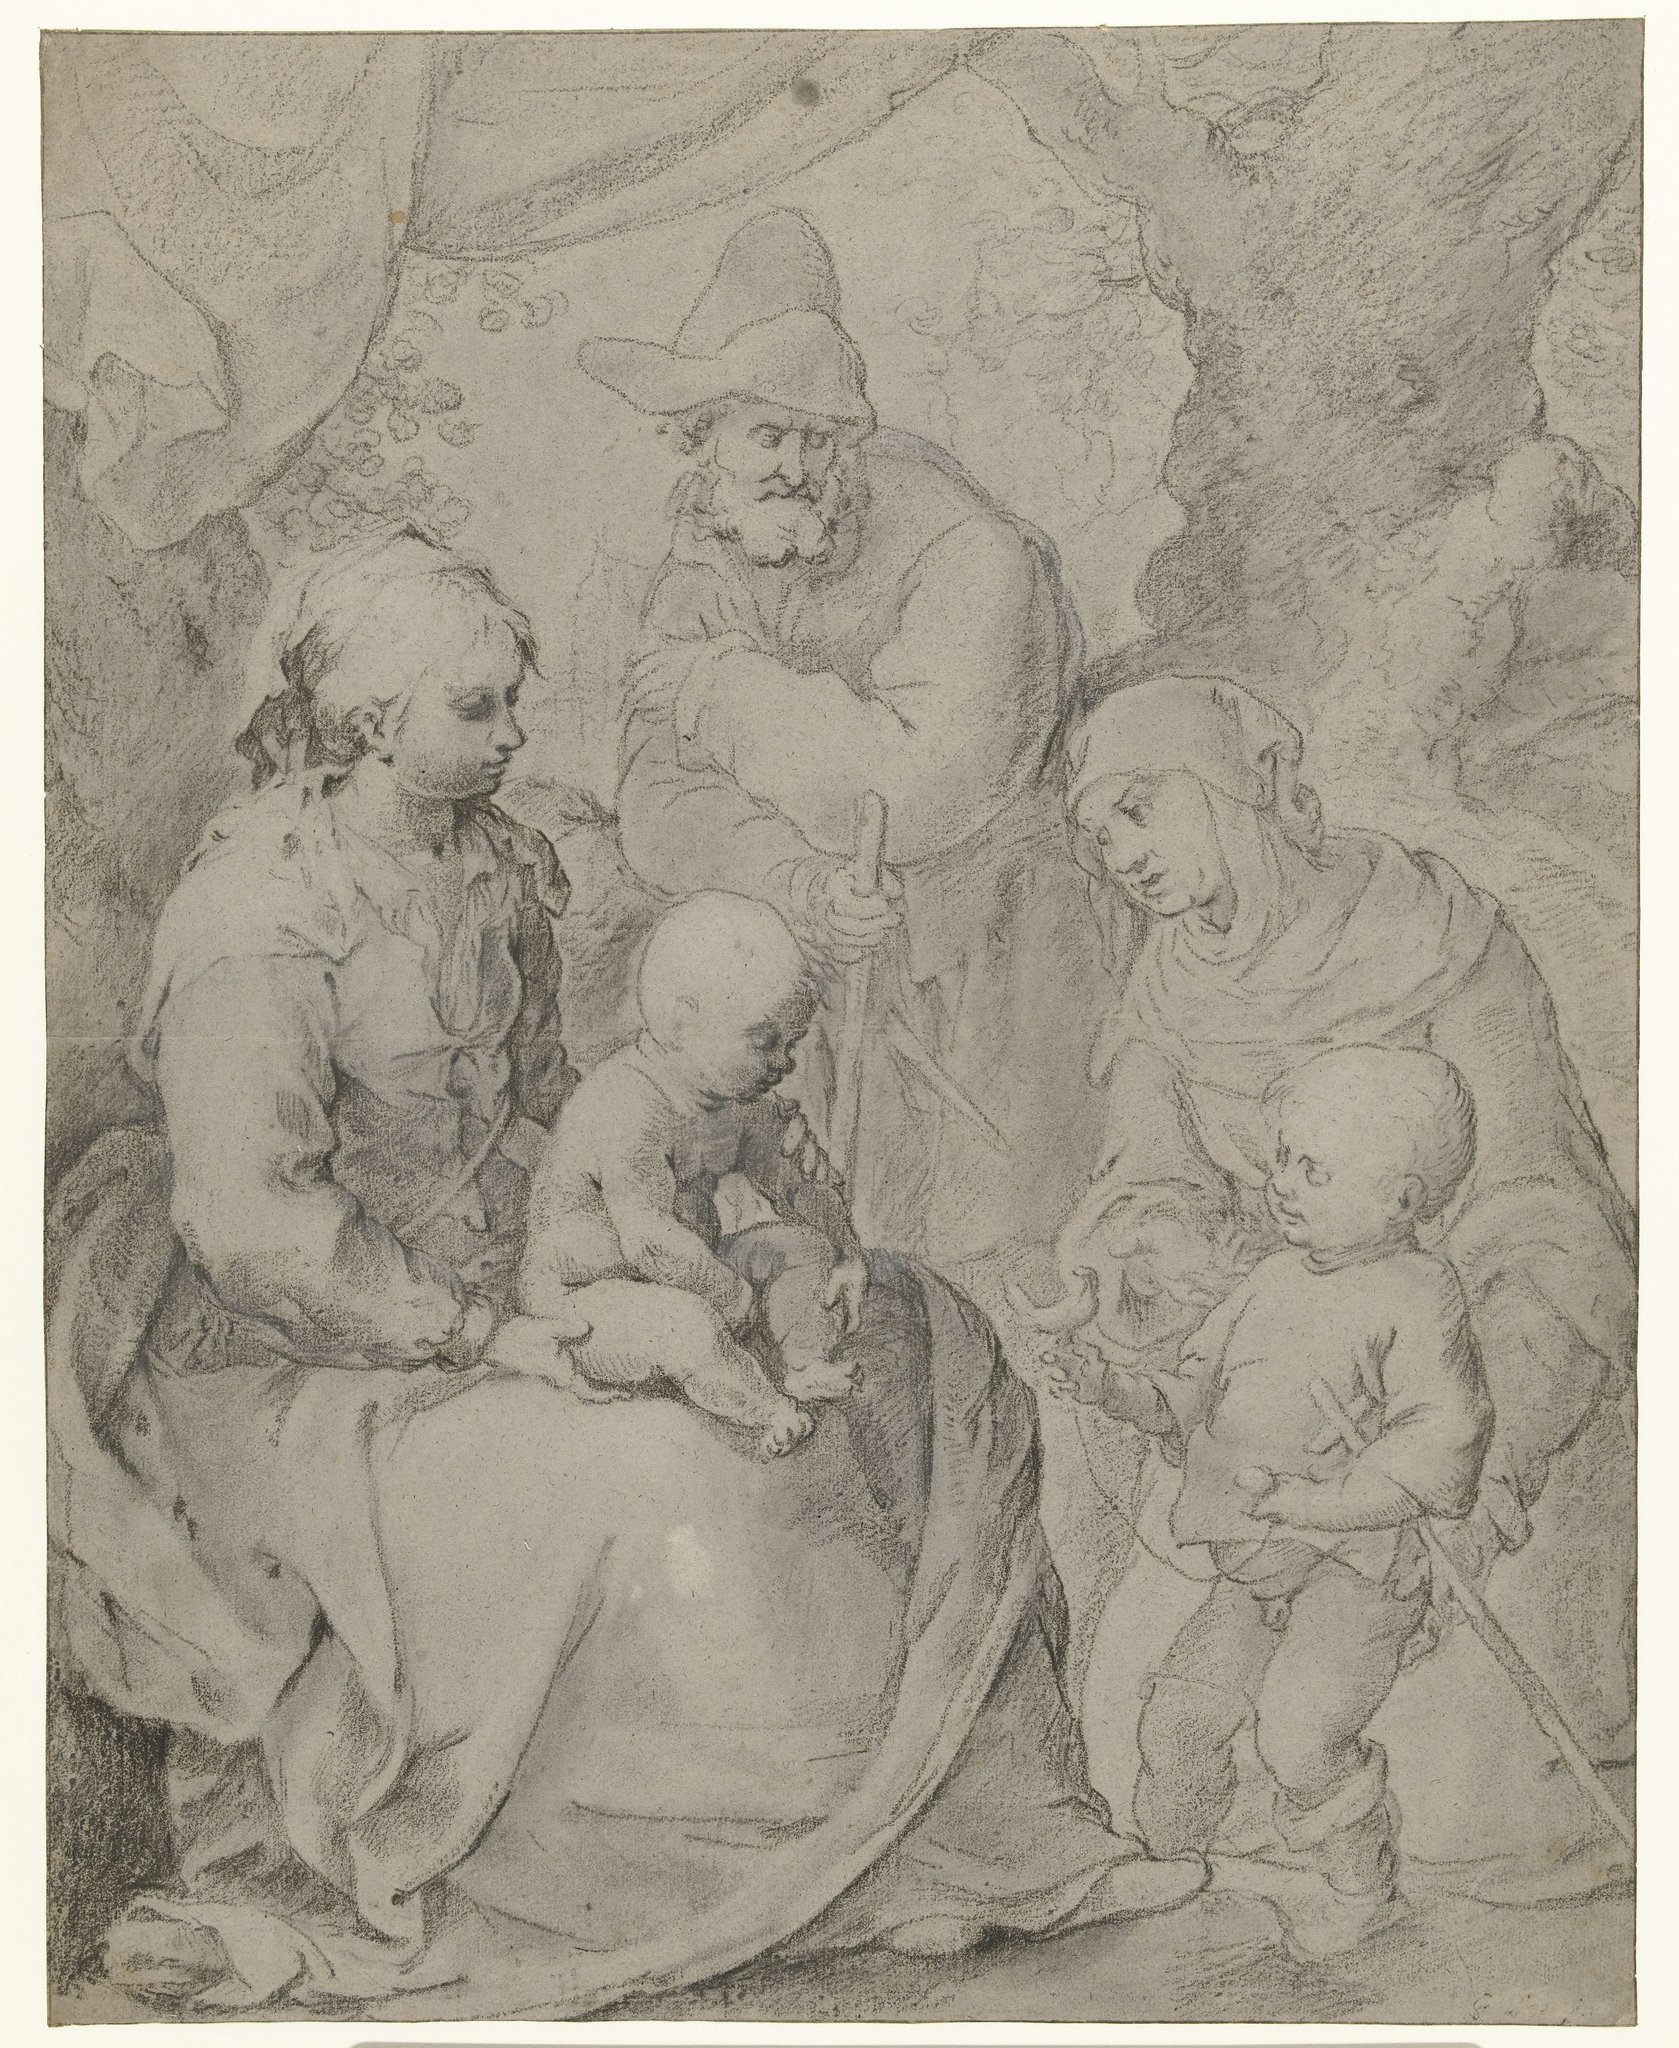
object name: design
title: Heilige familie met Elizabeth en Johannes de Doper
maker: paulus willemsz. van vianen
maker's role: draughtsman, jeweler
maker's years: 1570-1614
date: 1580-1610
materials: chalk, paper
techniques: brush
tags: holy family with john the baptist (as child)